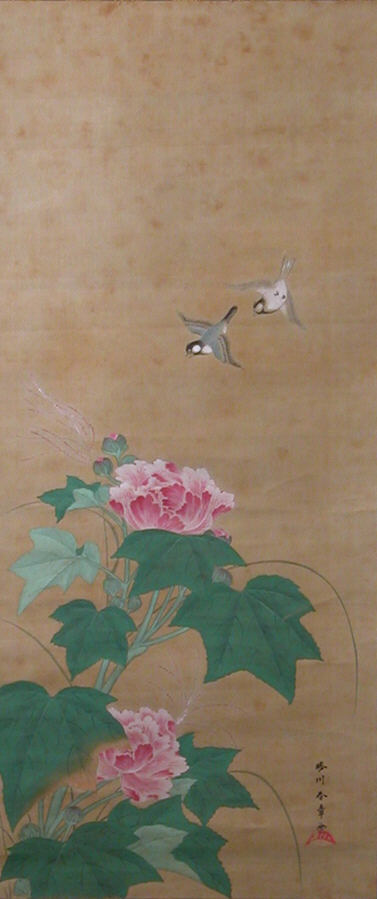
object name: hanging scroll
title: Rose Mallow (Fuyō)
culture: japanese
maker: katsukawa shunshō 勝川春章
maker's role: artist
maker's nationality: japanese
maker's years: 1726-1792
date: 1701-1800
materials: ink, silk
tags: birds,flowers